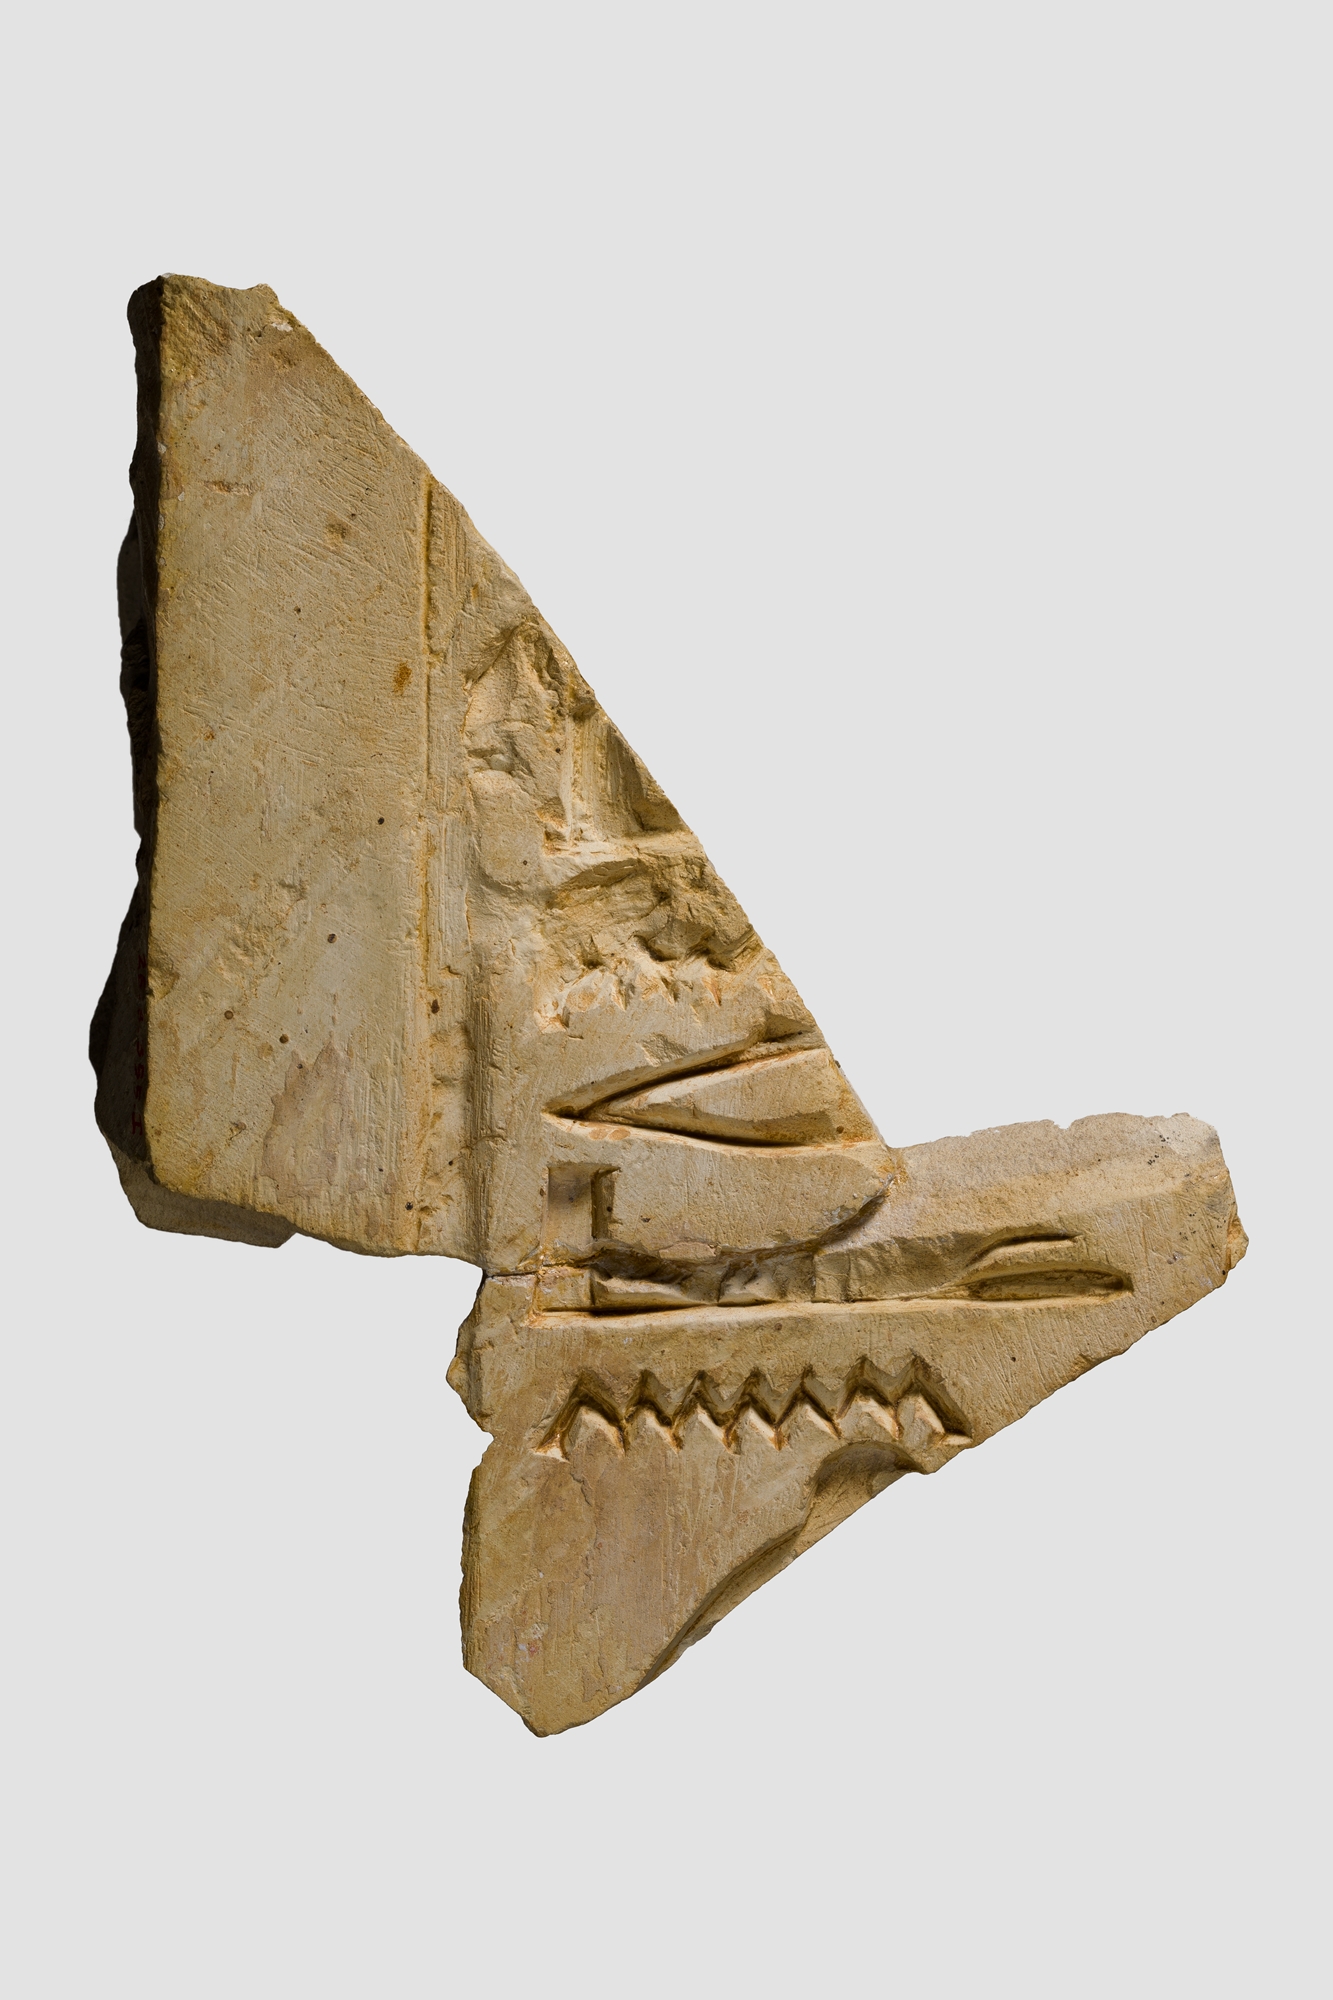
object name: relief fragment, neferu or khety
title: Relief Fragment from the Tomb of Neferu or Khety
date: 2030-1640 BCE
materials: limestone, paint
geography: egypt